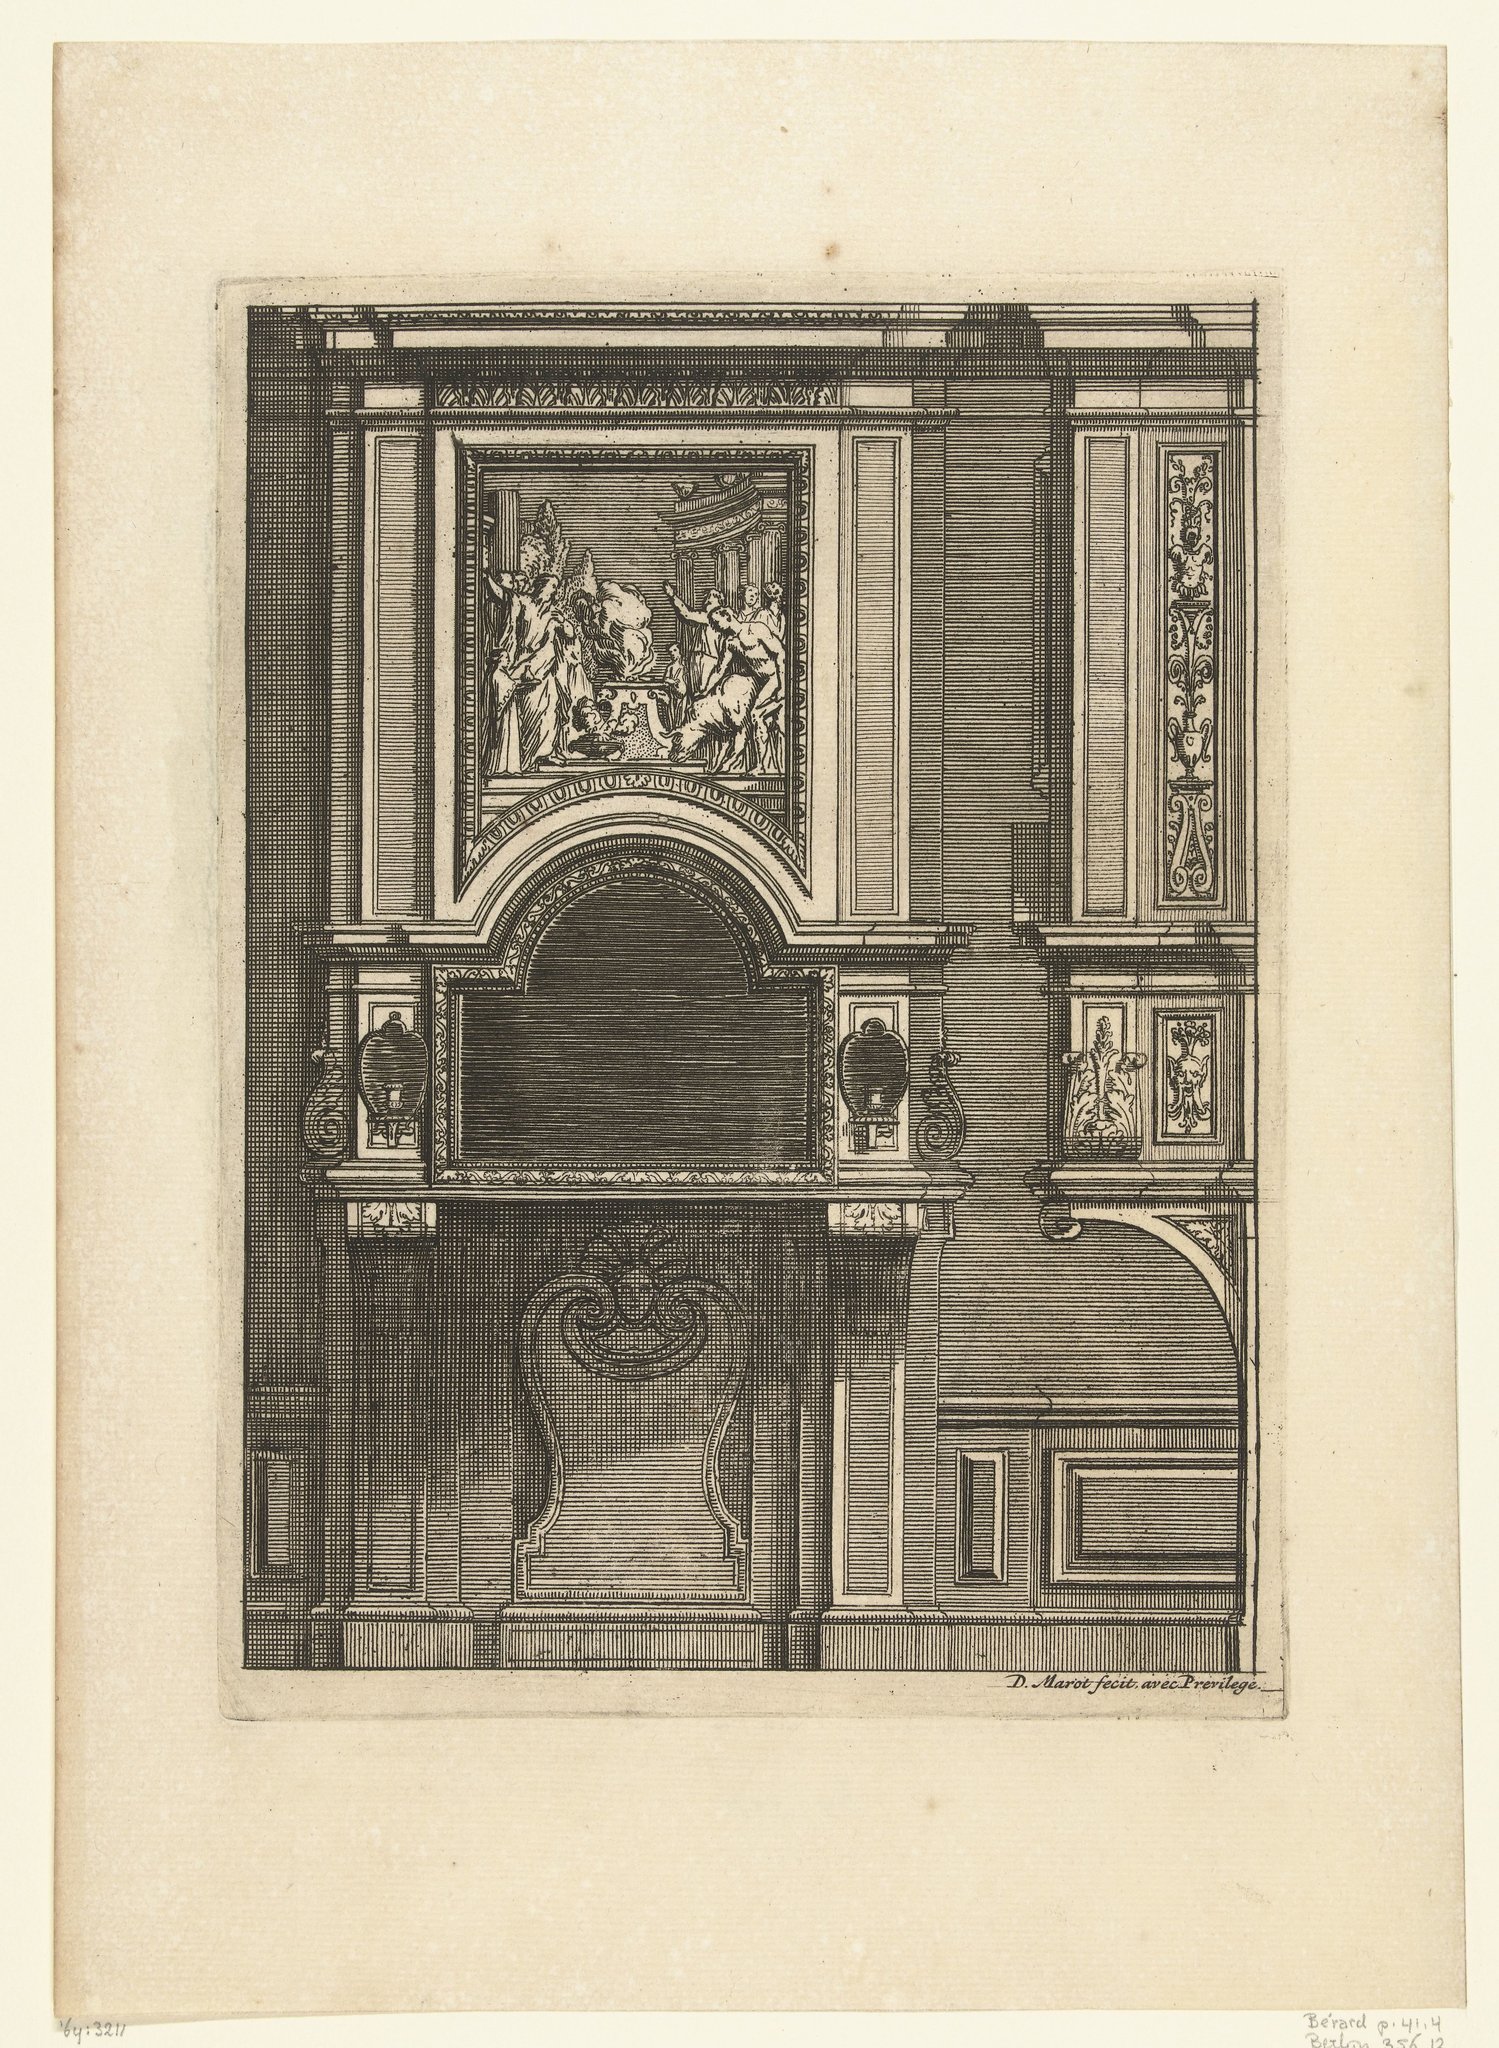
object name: ornament print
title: Nouveaux Liure de Cheminées a la Hollandaise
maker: daniël marot (i)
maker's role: draughtsman, print maker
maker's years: 1661-1752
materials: paper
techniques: etching